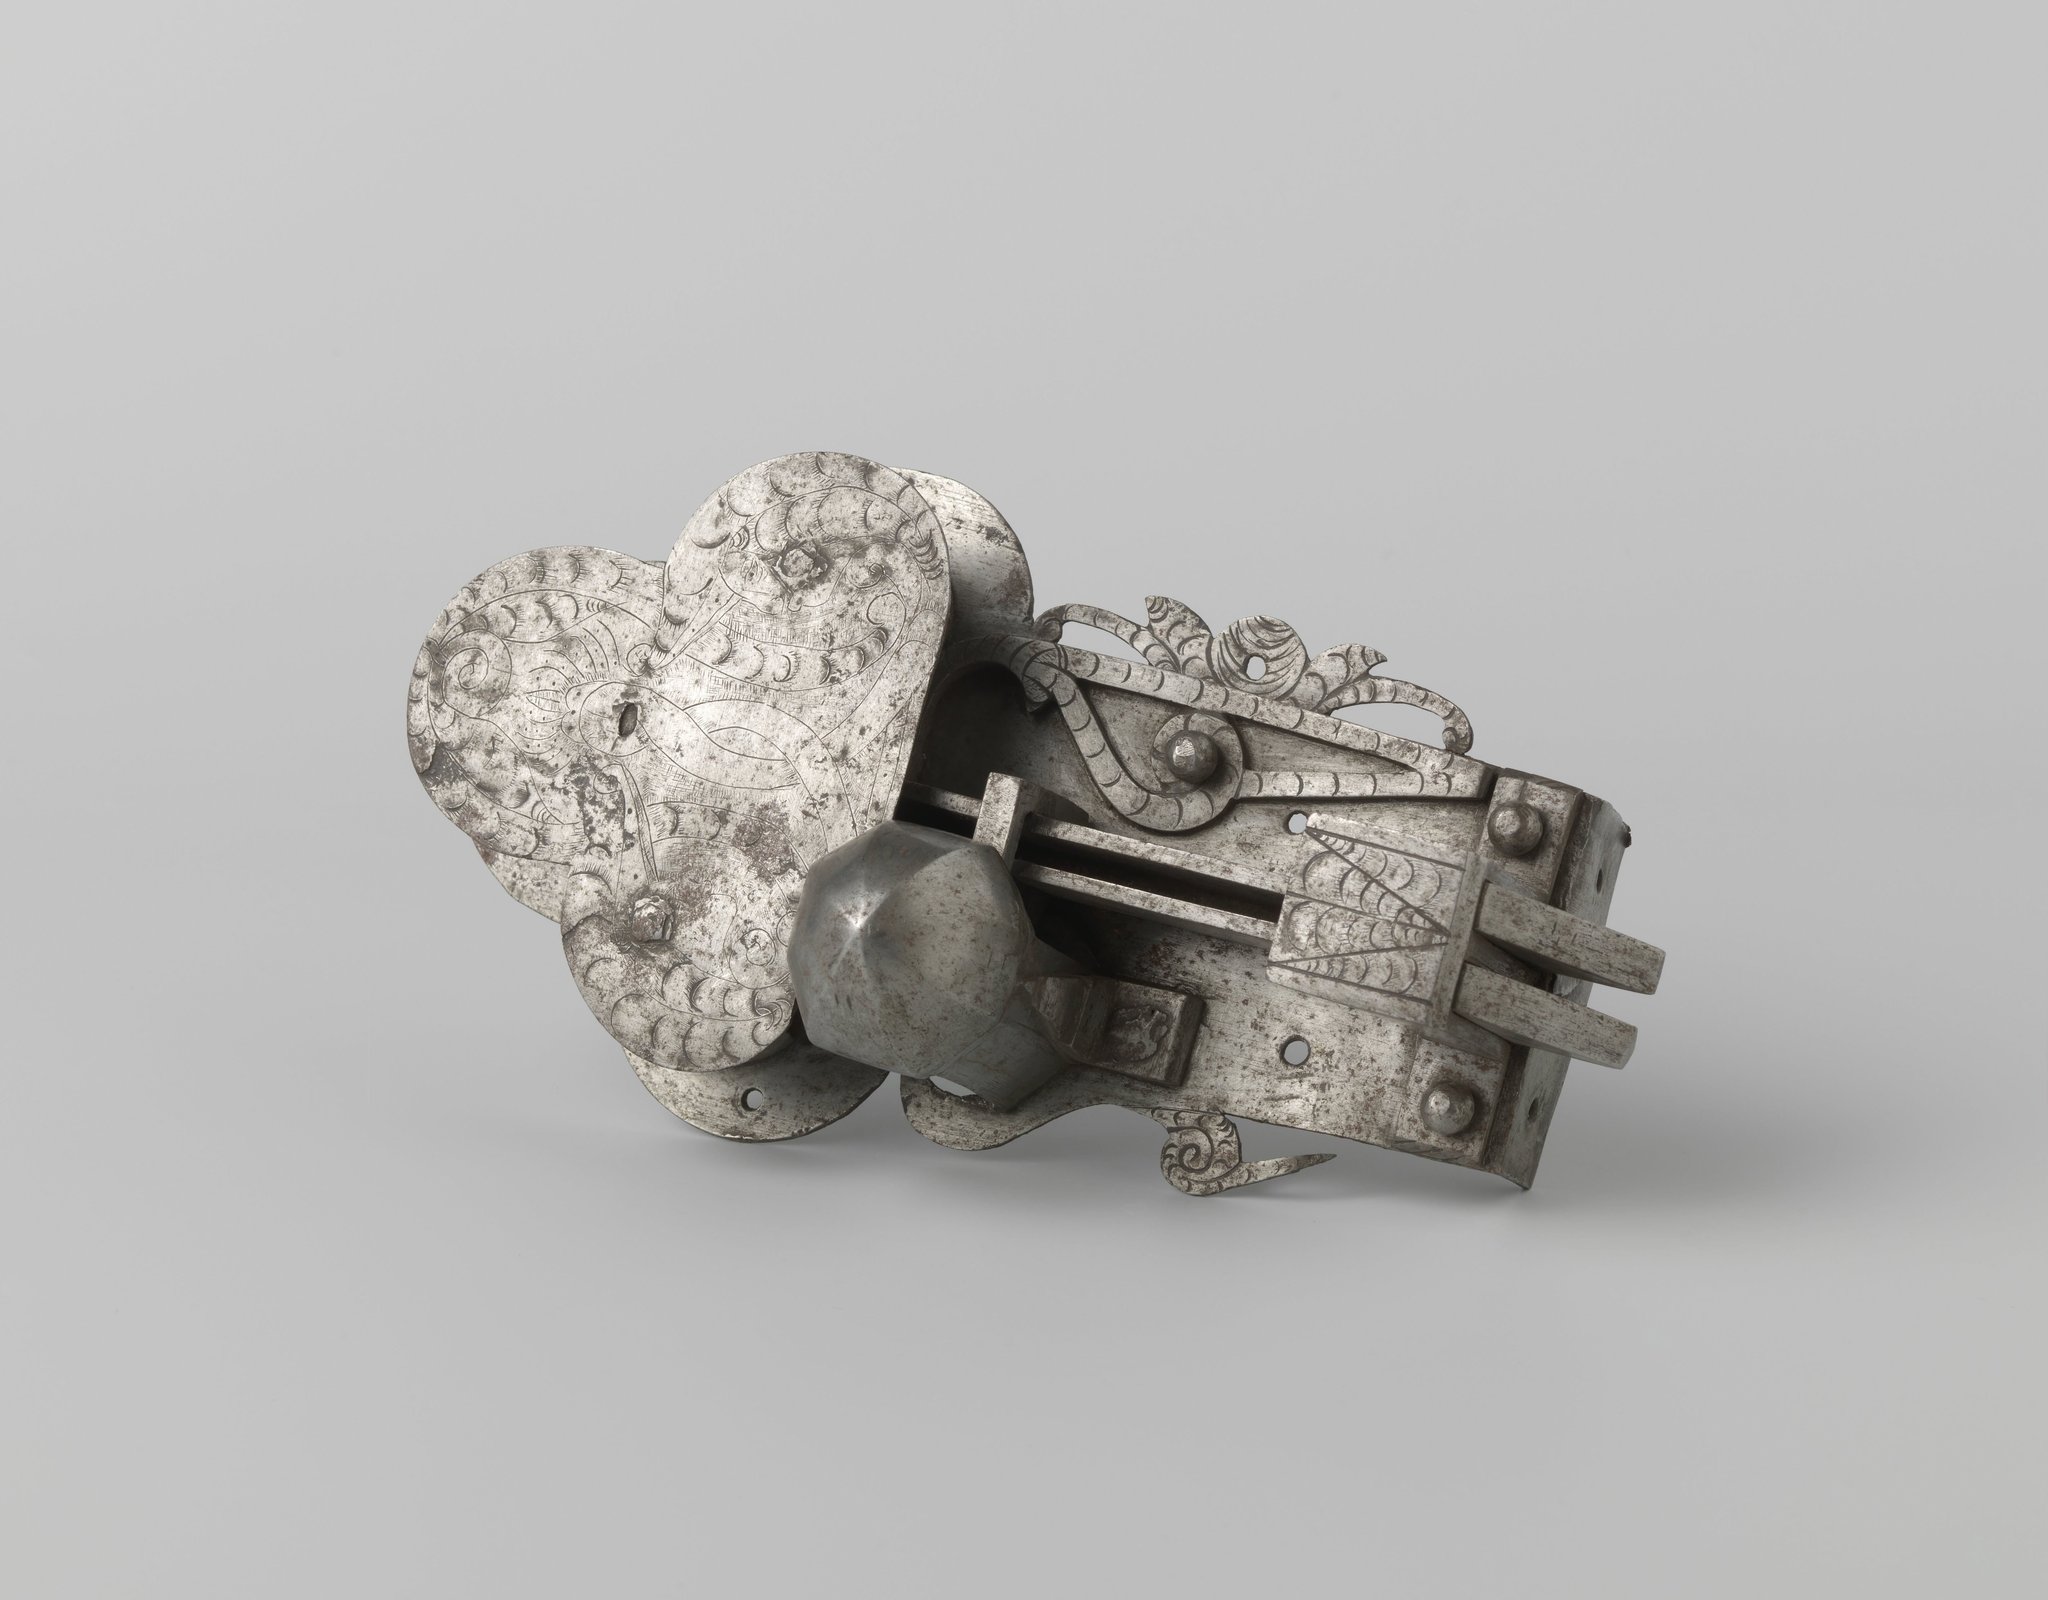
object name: rim lock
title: Slot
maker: Anonymous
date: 1600-1699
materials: iron, tin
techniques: engraving, tinning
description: Slot van vertind ijzer, zogenaamd oplegslot met twee schoten. Een klavervormige slotkast. De slotplaat is met gevlochten ranken gegraveerd, waarbij de ranken eindigen in gezichten erin.